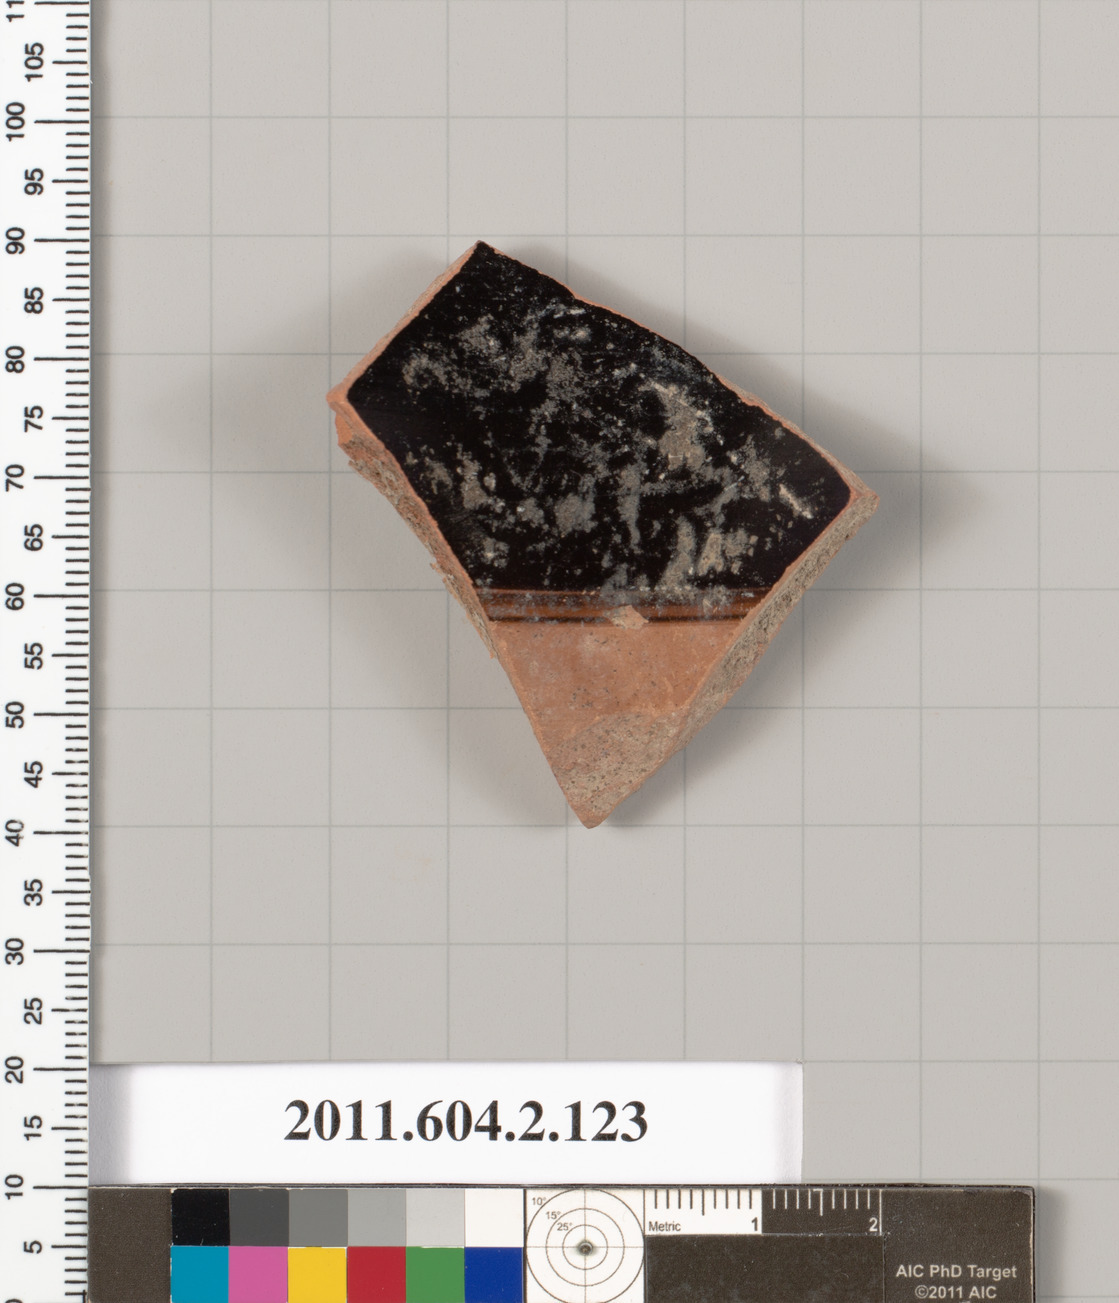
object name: pelike fragment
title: Terracotta fragment of a pelike (jar)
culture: greek, attic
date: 460-450 BCE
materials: terracotta